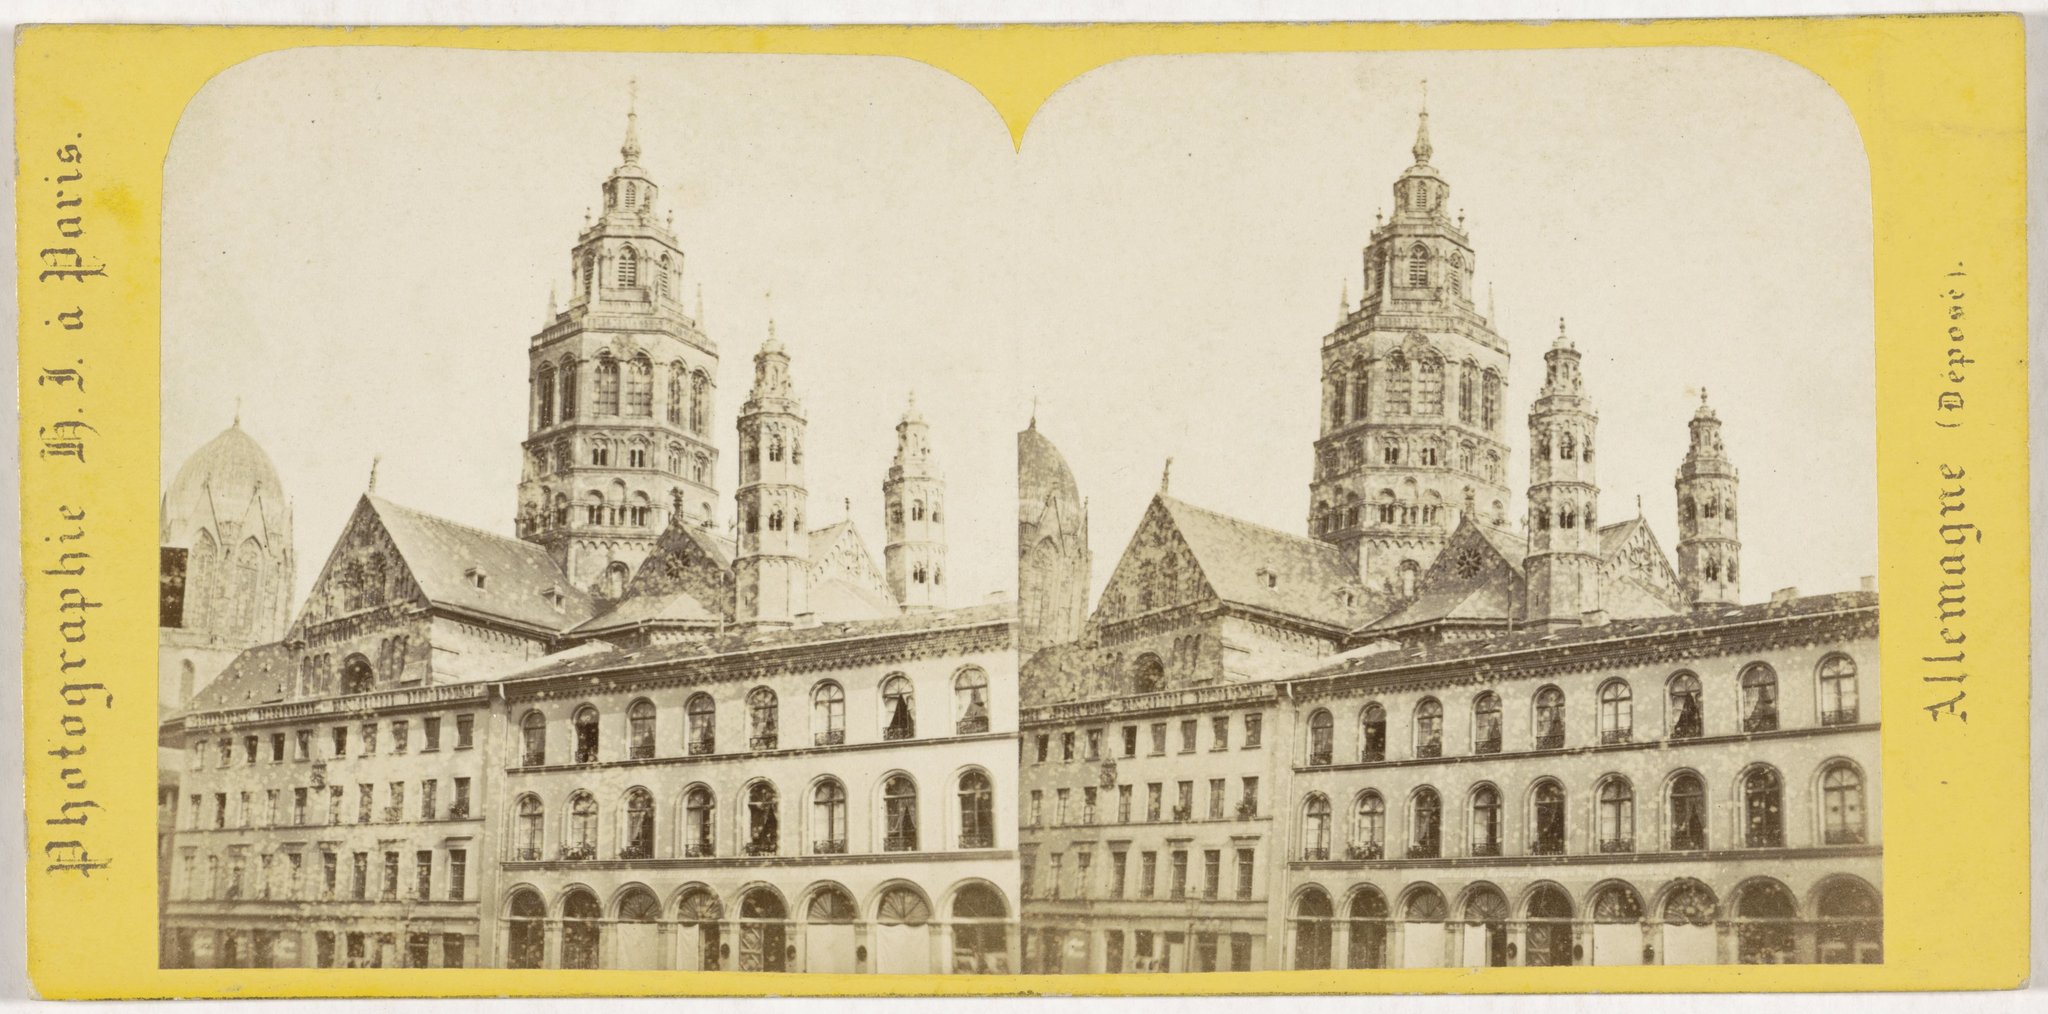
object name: stereograph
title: Mayence (Hesse-Darmstadt), vue sur la cathédrale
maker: hippolyte jouvin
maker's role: fotograaf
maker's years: 1825-1889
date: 1860-1865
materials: cardboard, paper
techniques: albumen print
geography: mainz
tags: urban housing, parts of church exterior and annexes: tower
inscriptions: number: ‘N. 420’, inscription: ‘(Déposé).’, inscription: ‘Déposé.’